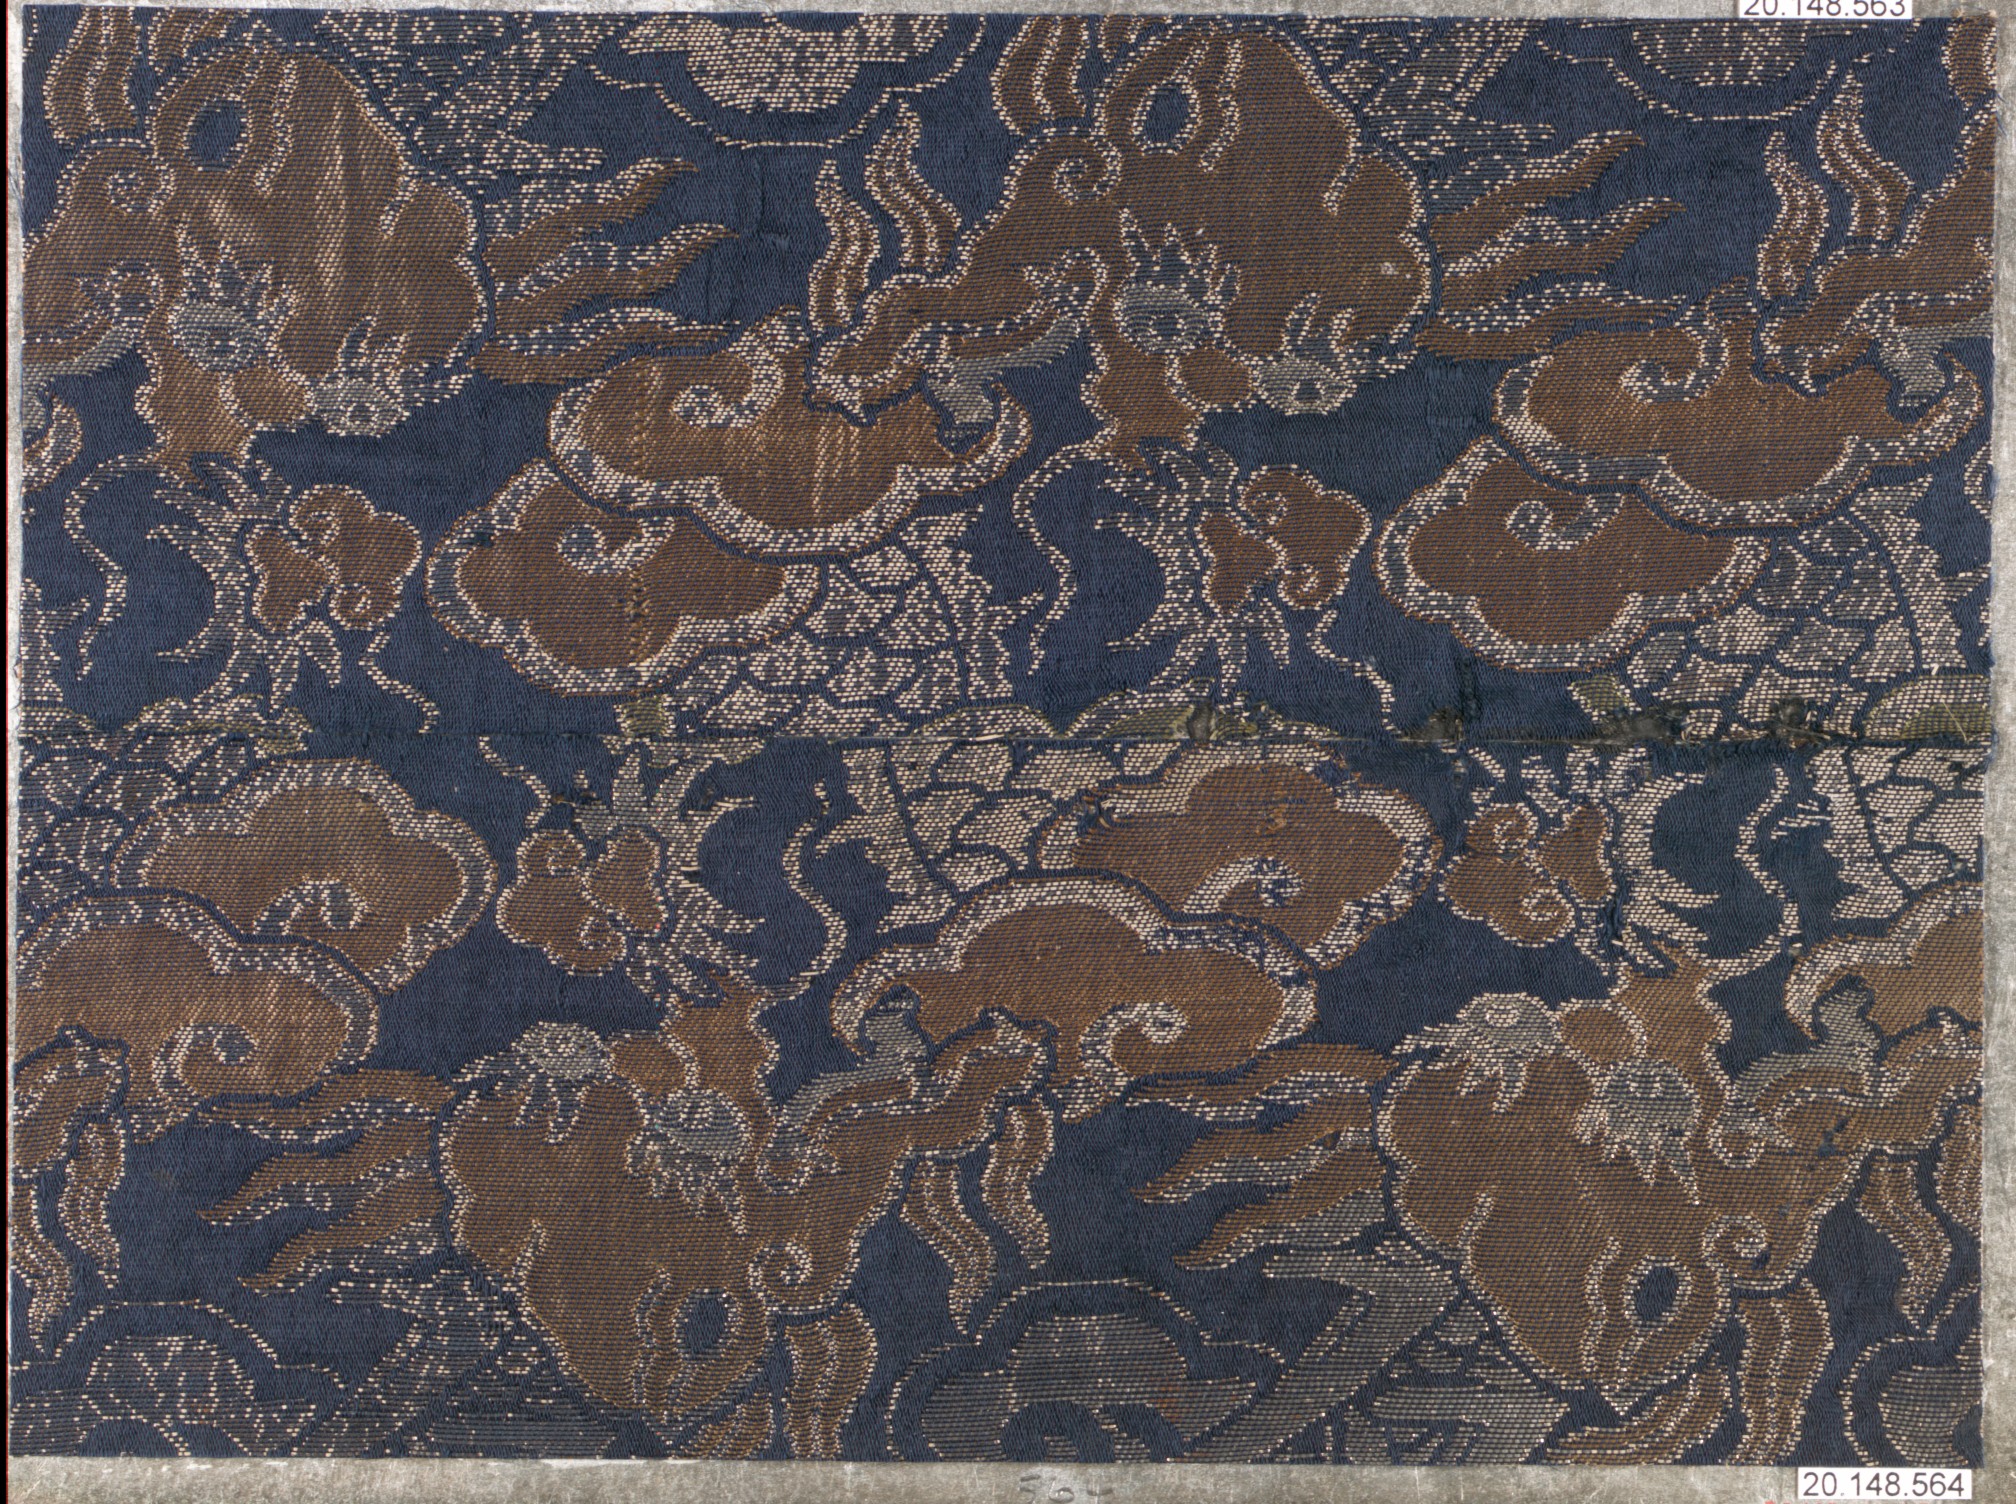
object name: piece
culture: chinese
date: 1701-1800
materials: silk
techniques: compound weave